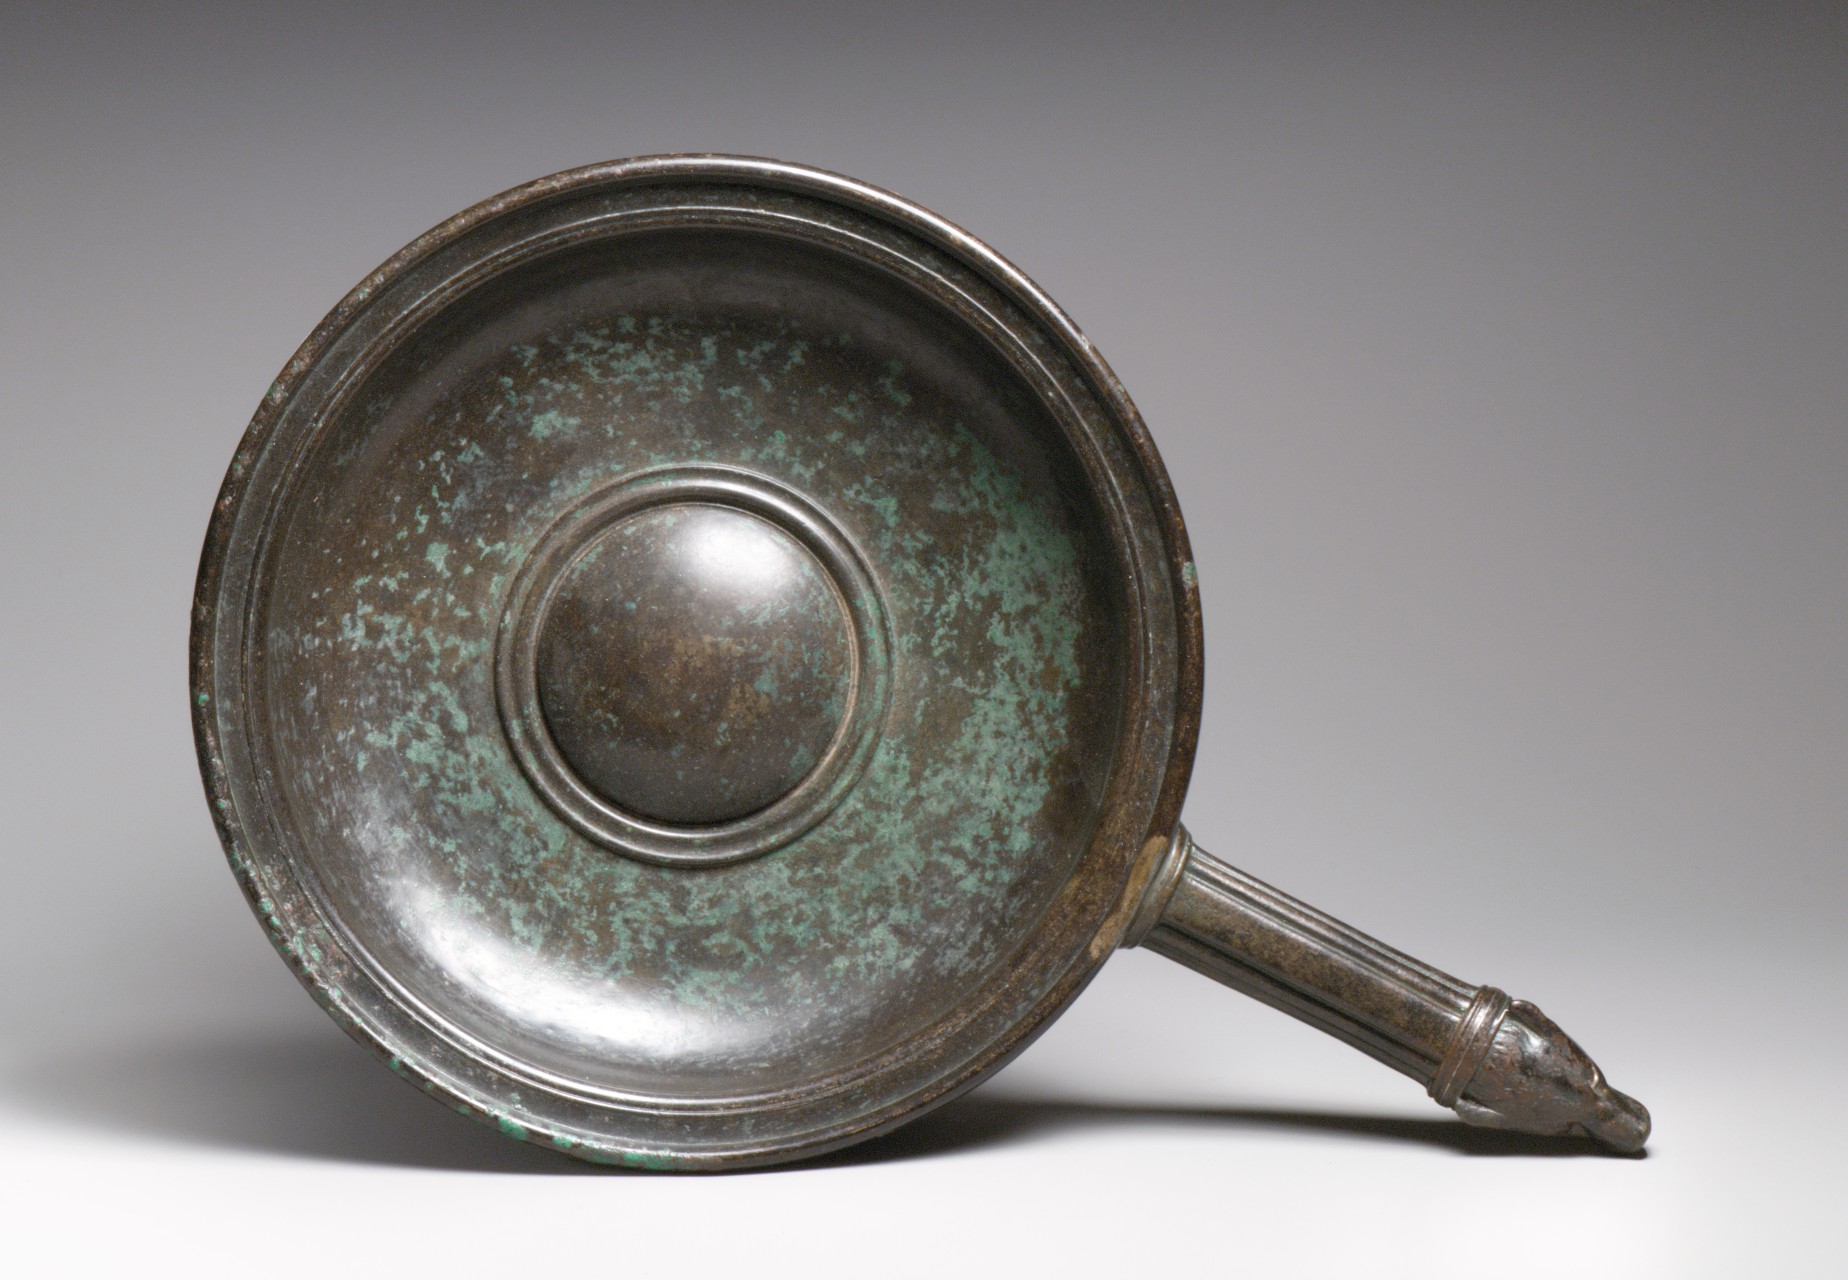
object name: patera with wolf head handle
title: Bronze patera (shallow bowl with handle)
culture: roman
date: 1-33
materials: bronze